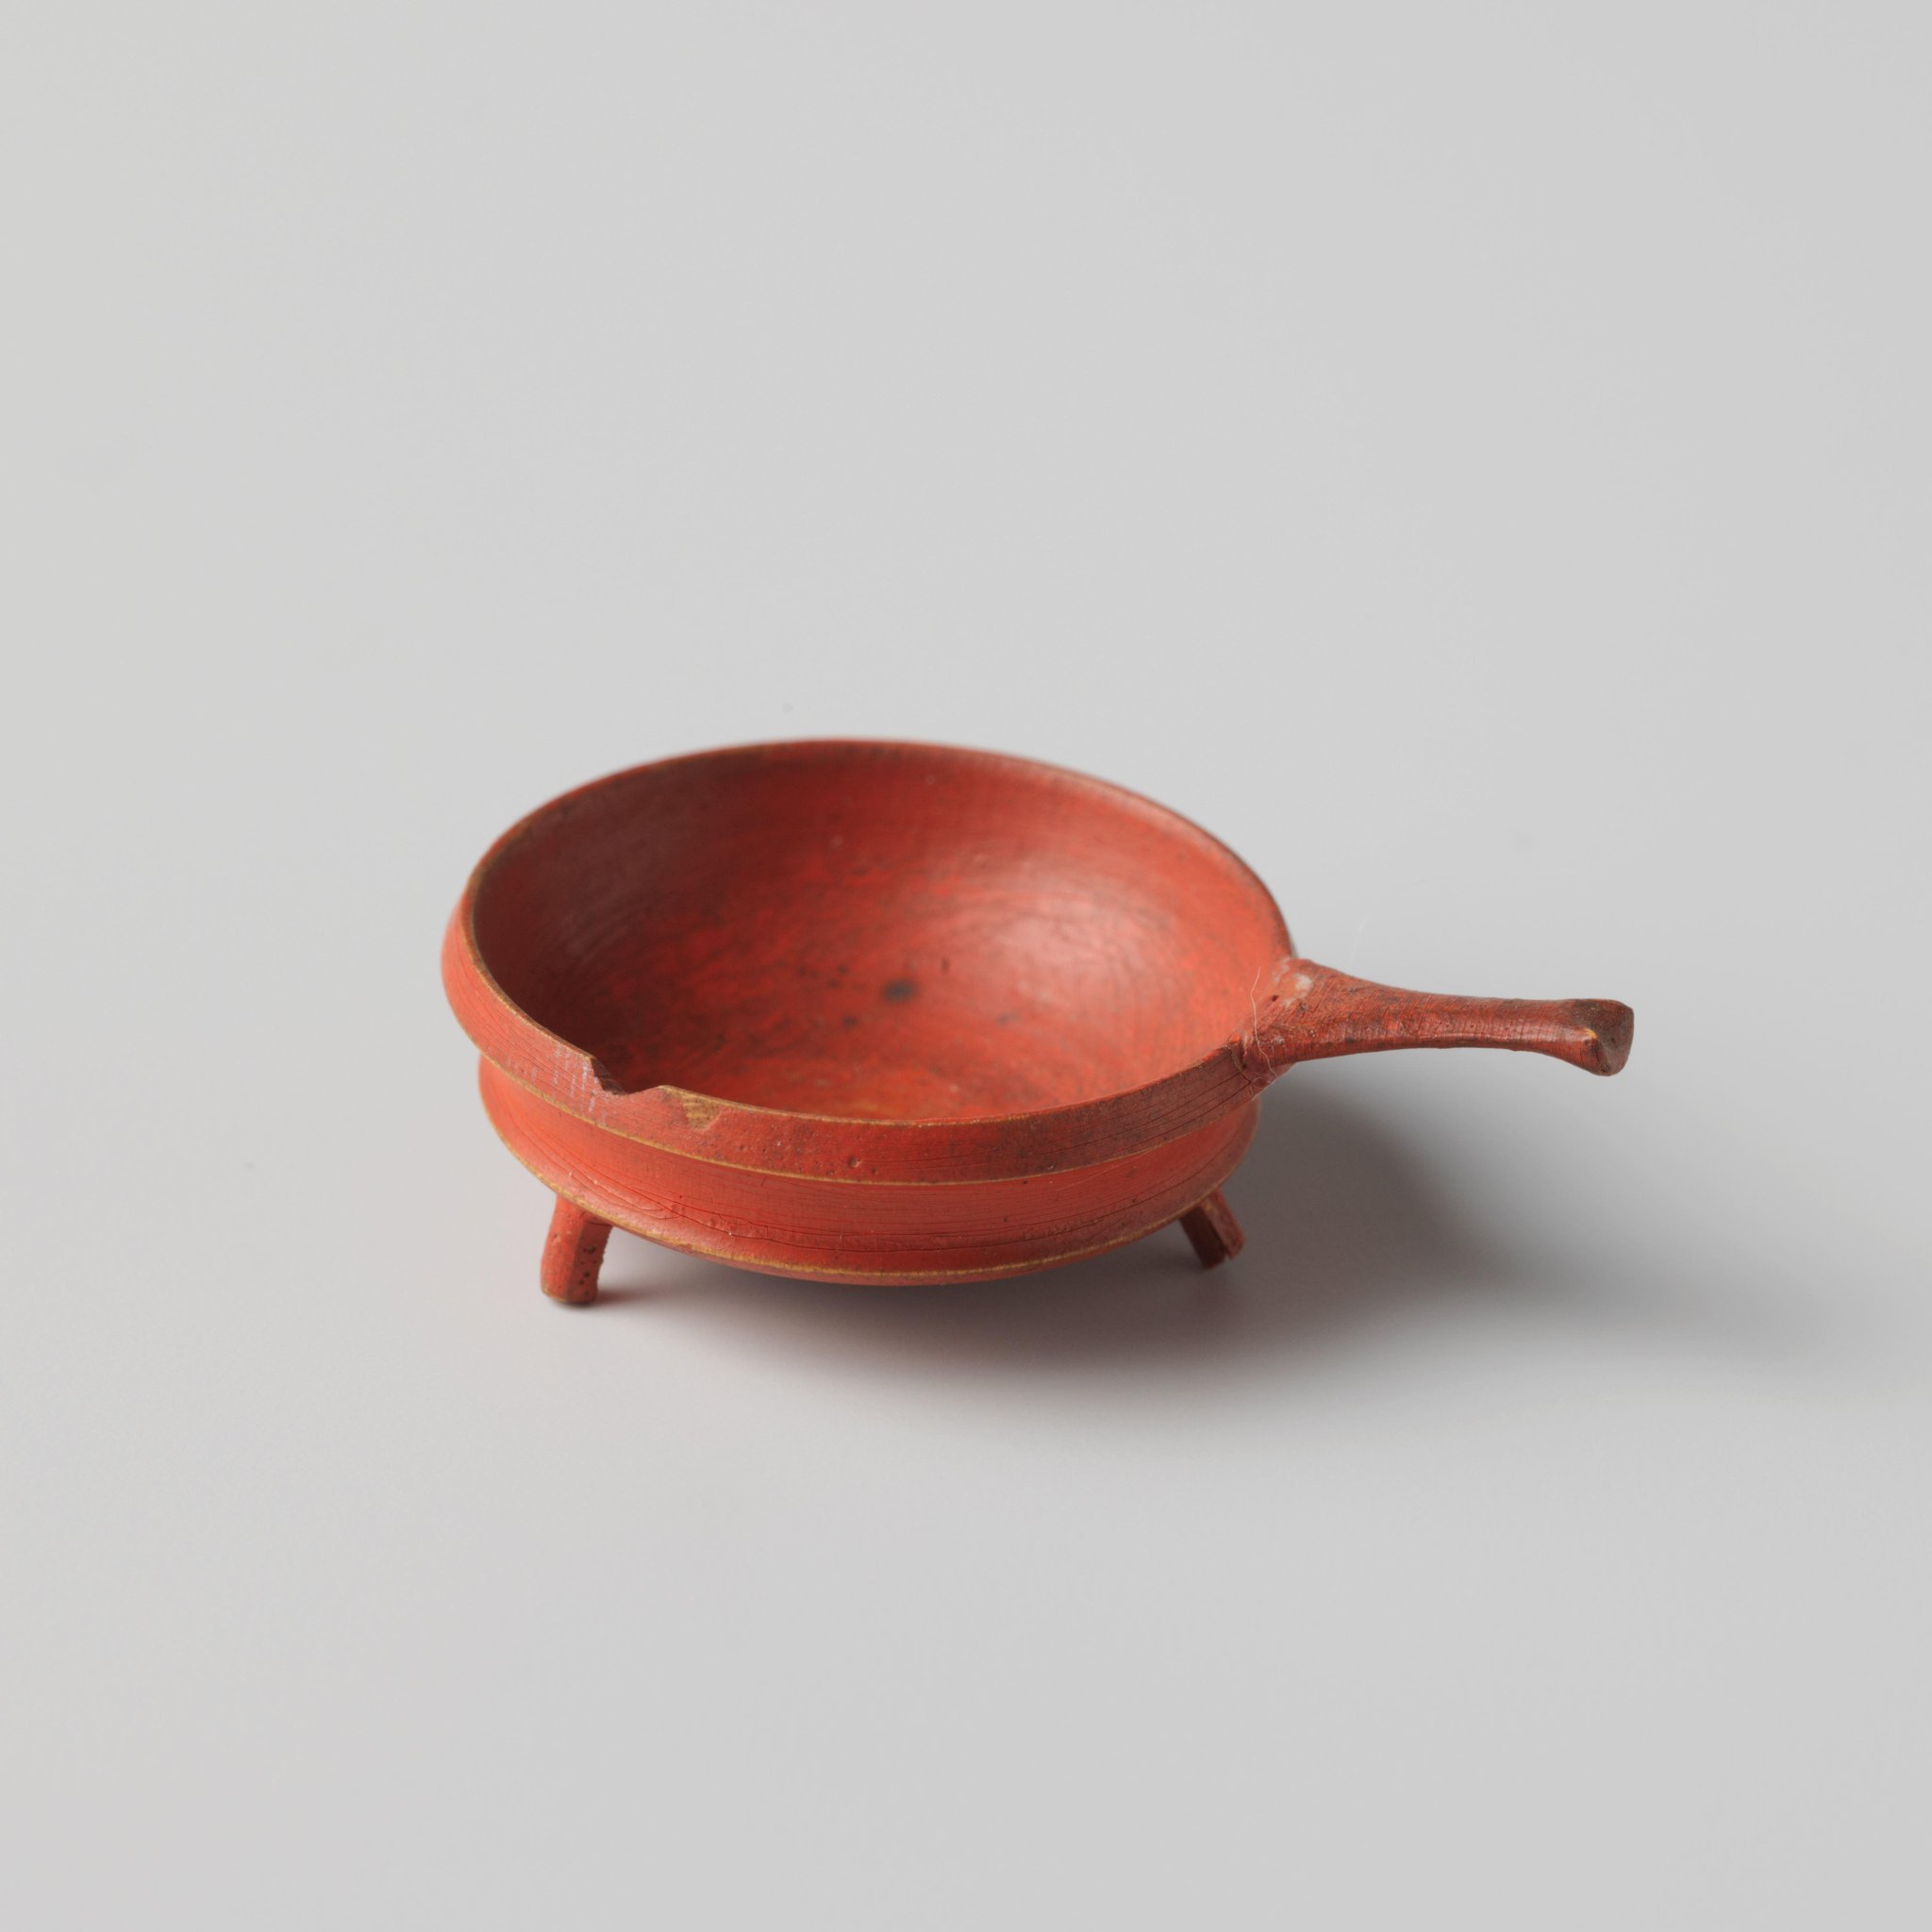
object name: miniature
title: Steelpan op drie poten, roodgeverfd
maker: Anonymous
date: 1675-1700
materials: wood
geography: amsterdam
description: Steelpan van gedraaid hout, op drie poten, roodgeverfd.